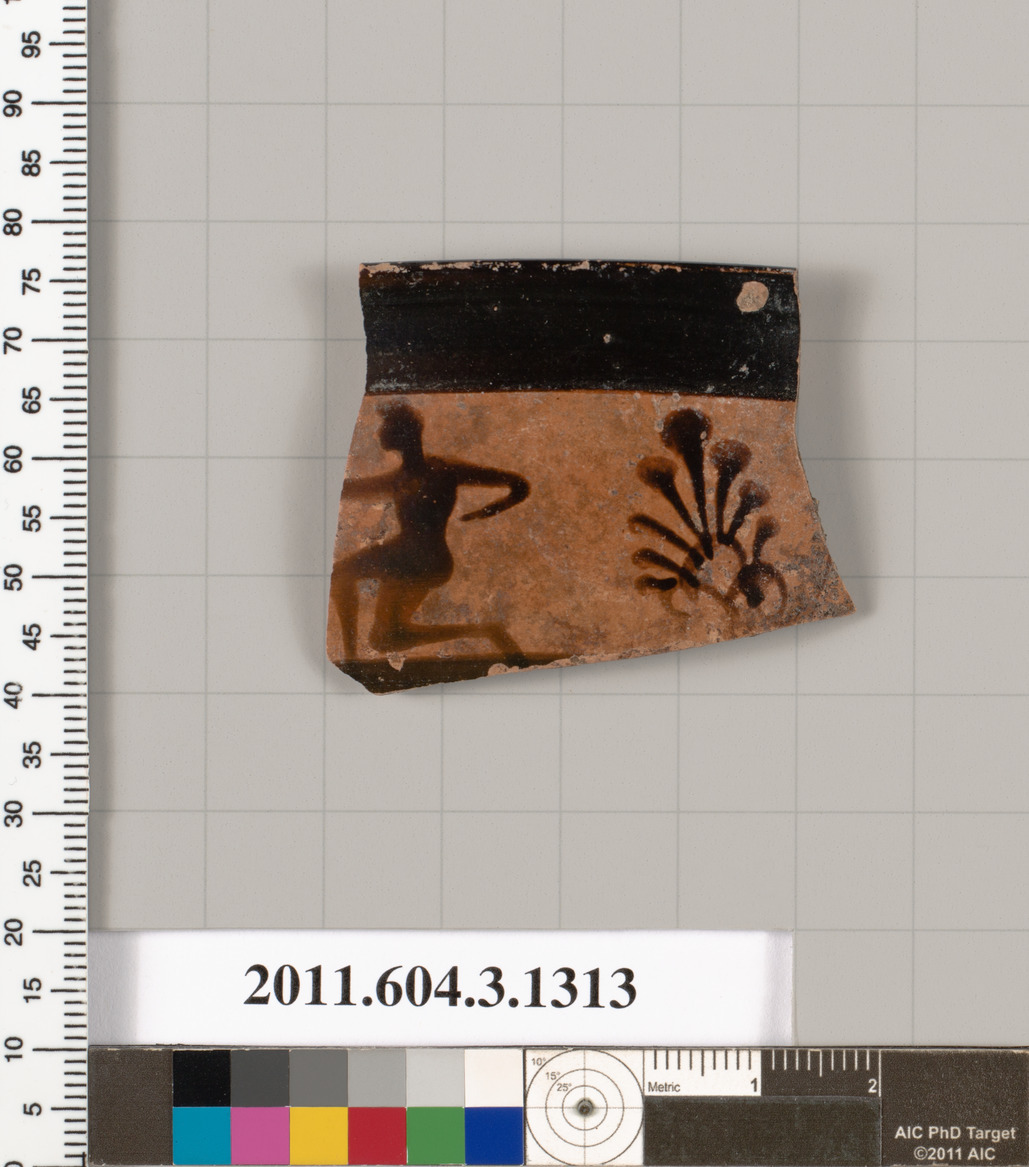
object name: skyphos fragment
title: Terracotta rim fragment of a skyphos (deep drinking cup)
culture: greek, attic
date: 490-480 BCE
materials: terracotta